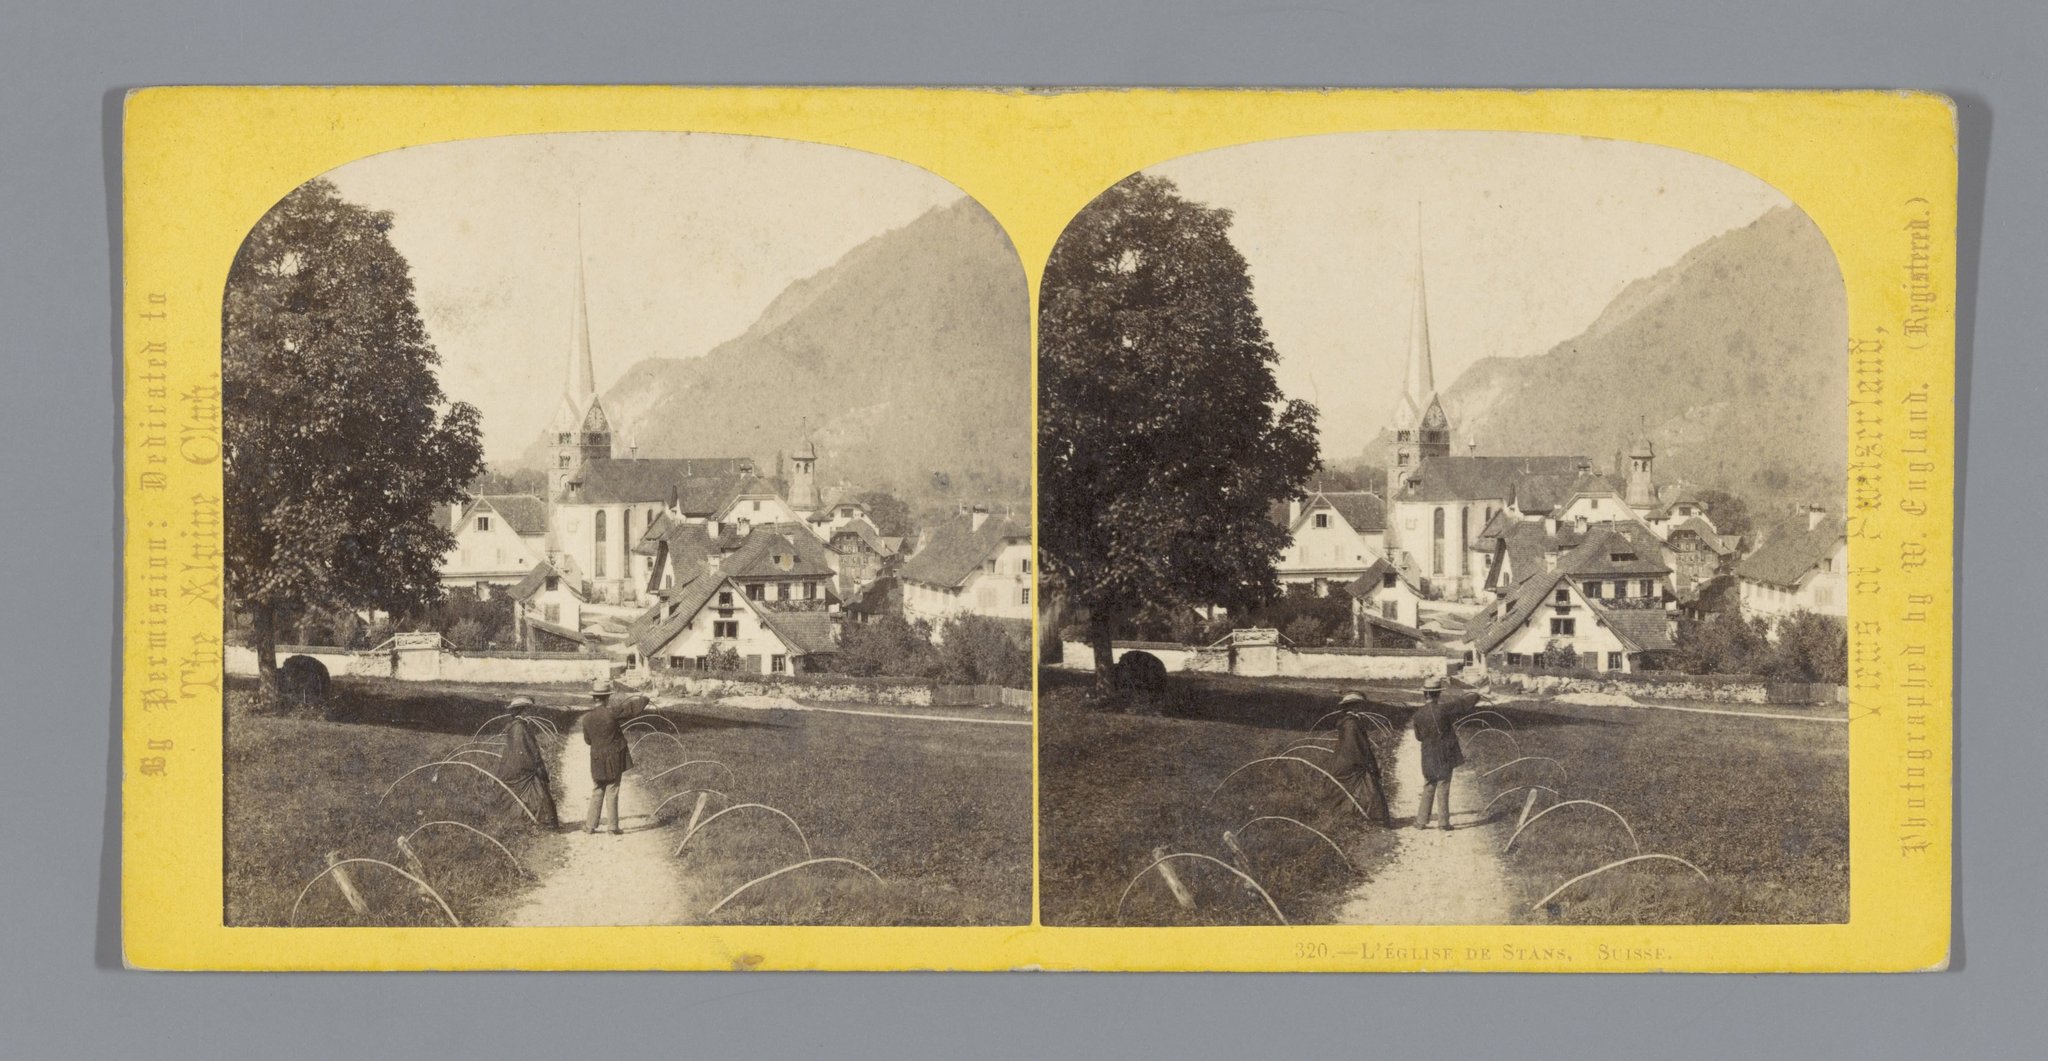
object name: stereograph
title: L'église de Stans, Suisse.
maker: william england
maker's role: fotograaf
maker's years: 1816-1896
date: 1850-1880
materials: cardboard, photographic support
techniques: albumen print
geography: stans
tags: church (exterior)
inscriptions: number: ‘320.’, inscription: ‘Views of Switzerland, photographed by W. England. (Registered) Under the Special Patronage of the Alpine Club.’